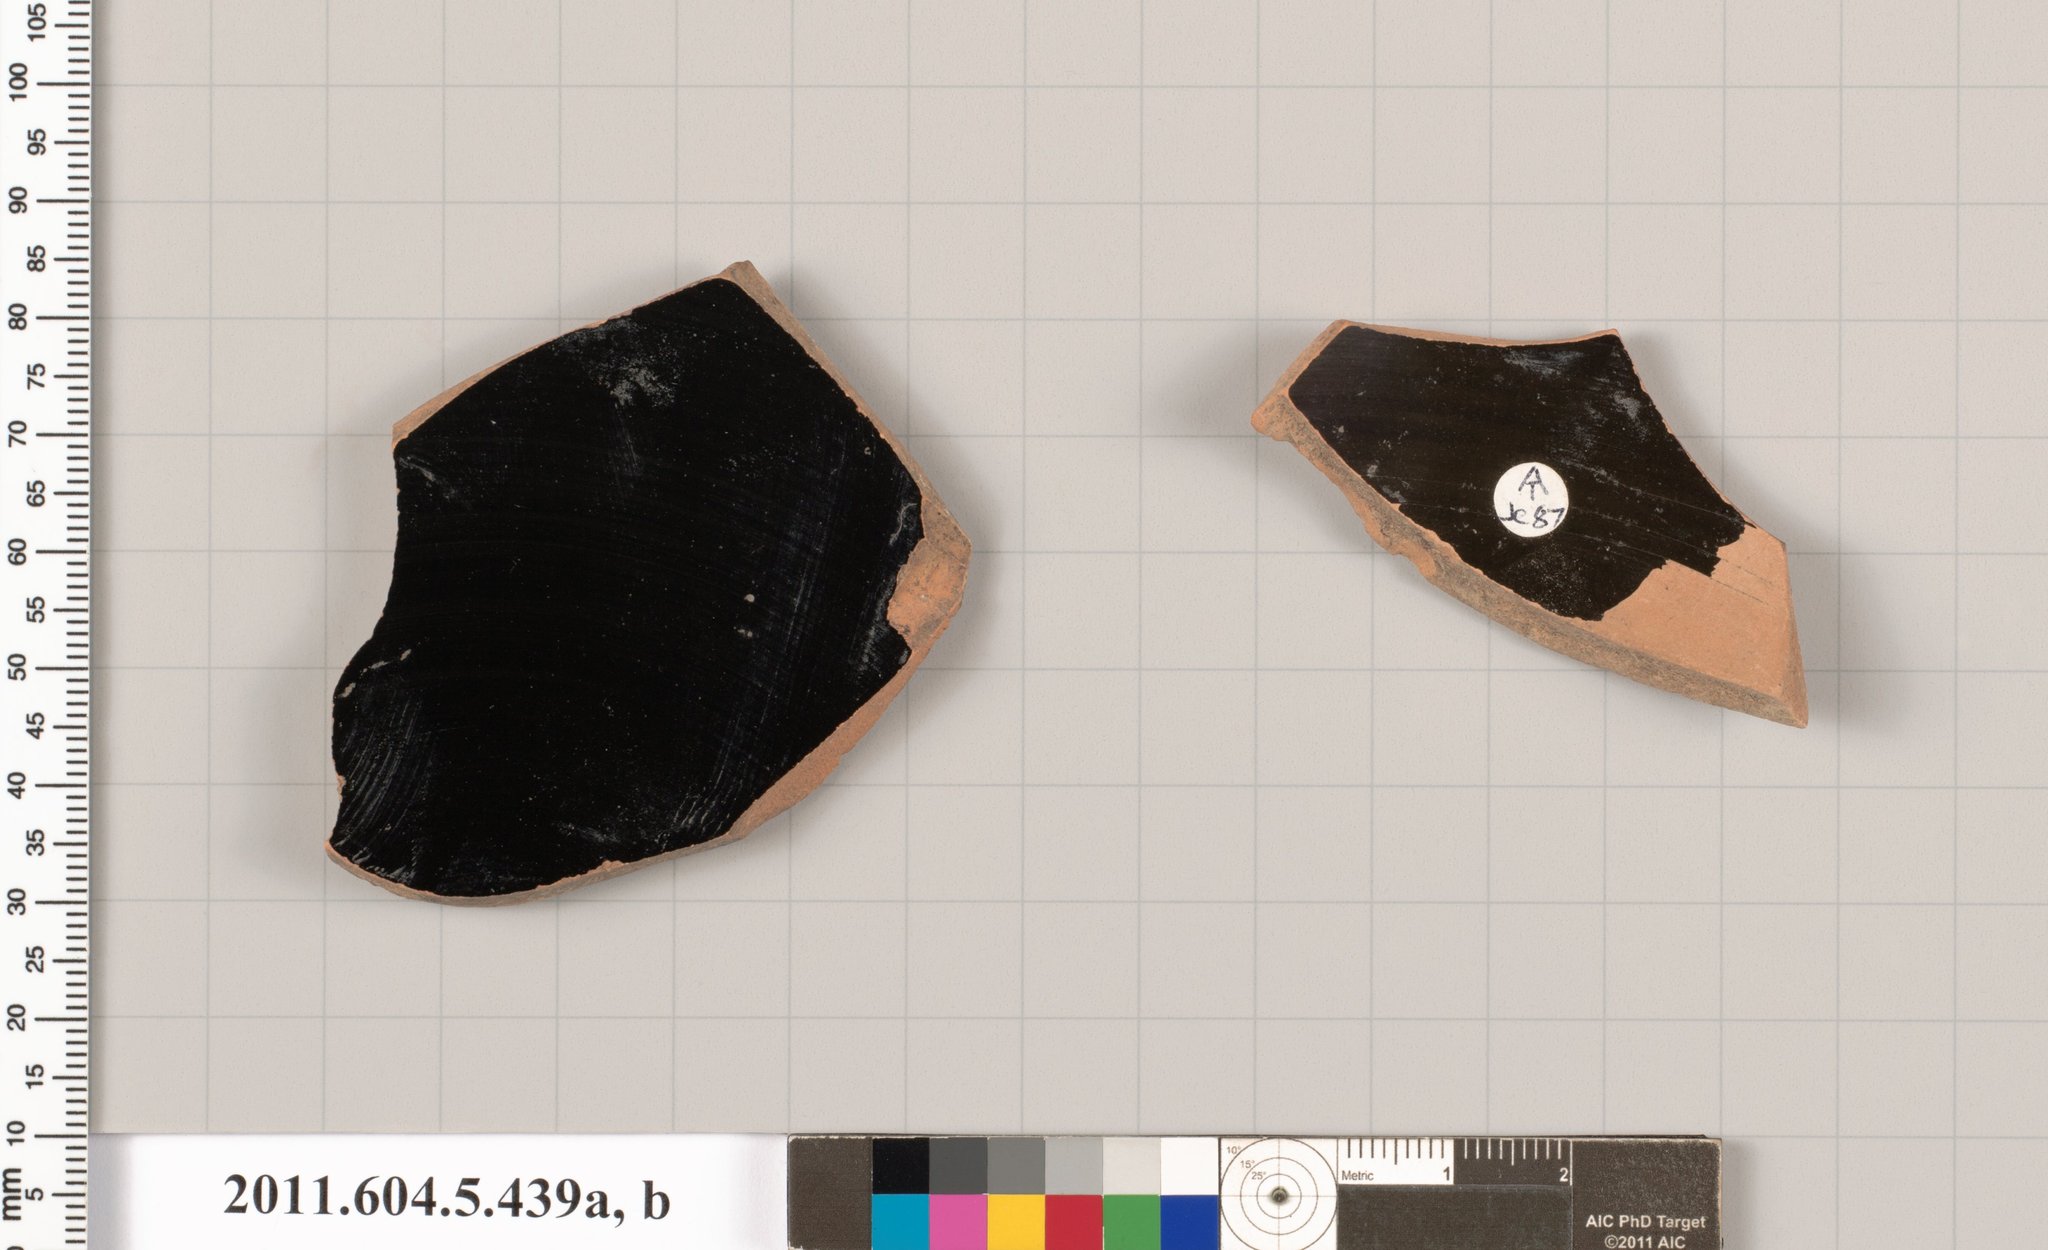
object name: kylix fragment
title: Terracotta fragments of kylikes (drinking cups)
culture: greek, attic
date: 600-401 BCE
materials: terracotta